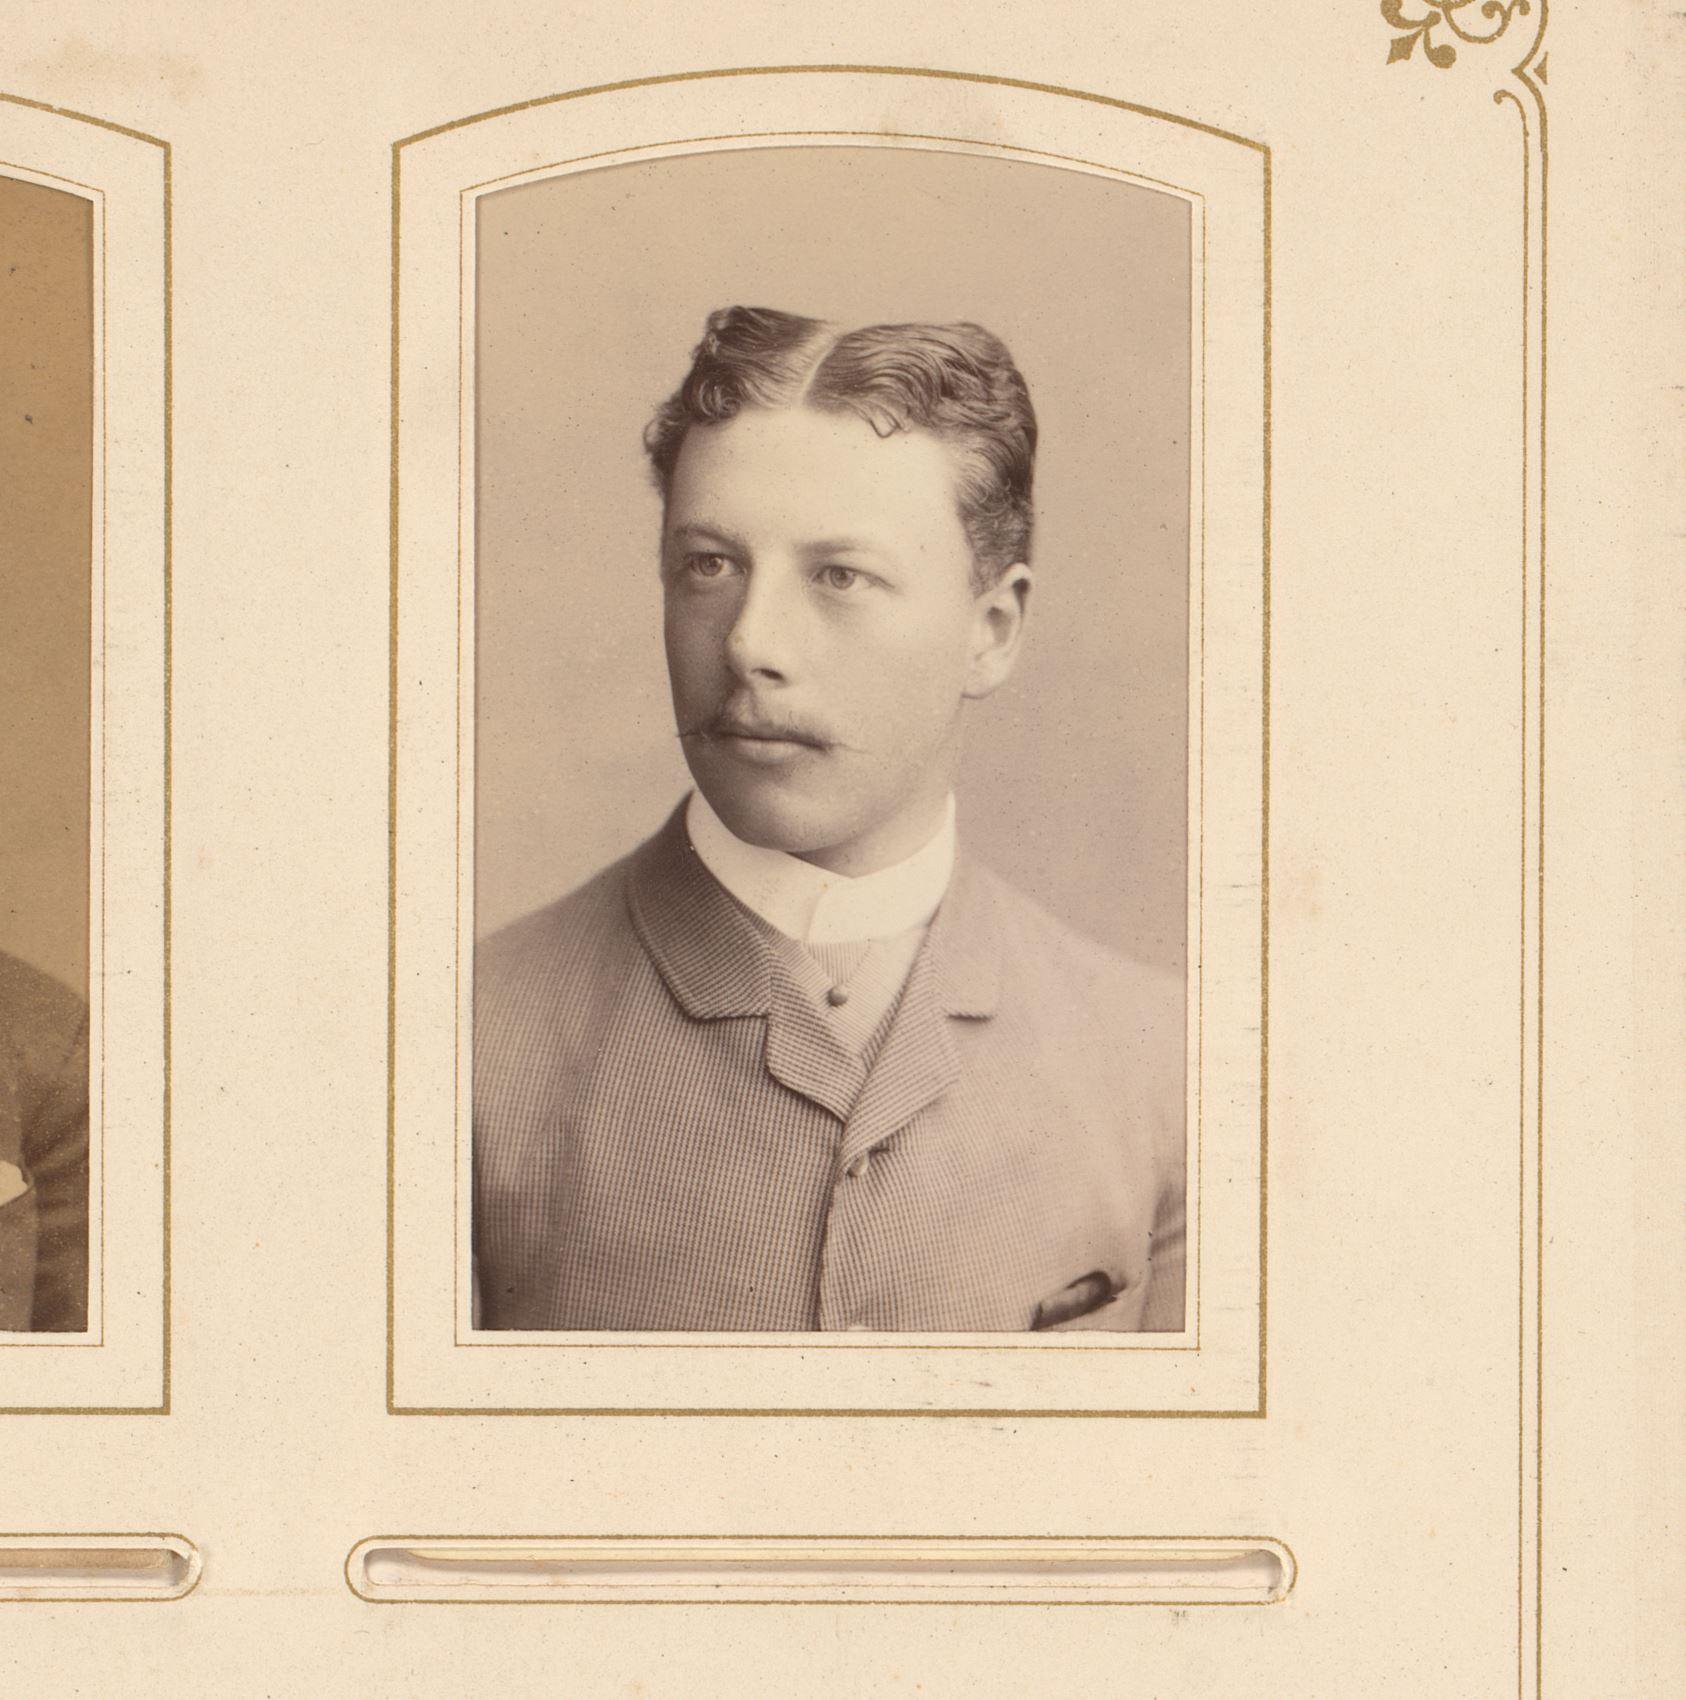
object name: carte de visite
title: Portret van een jonge man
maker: wilhelm höffert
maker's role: fotograaf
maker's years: 1832-1901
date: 1874-1904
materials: cardboard, photographic support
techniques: albumen print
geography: germany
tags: historical persons, youth, adolescent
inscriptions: inscription: ‘W. HÖFFERT/ KGL. SÄCHS. & KGL. PREUSS./ HOF-PHOTOGRAPH/ BERLIN/ LEIPZIGER PLATZ 12./ HAMBURG/ JUNGFERNSTIEG 6./ DRESDEN LEIPZIG/ HANNOVER/ GEORG-STR. 9.’